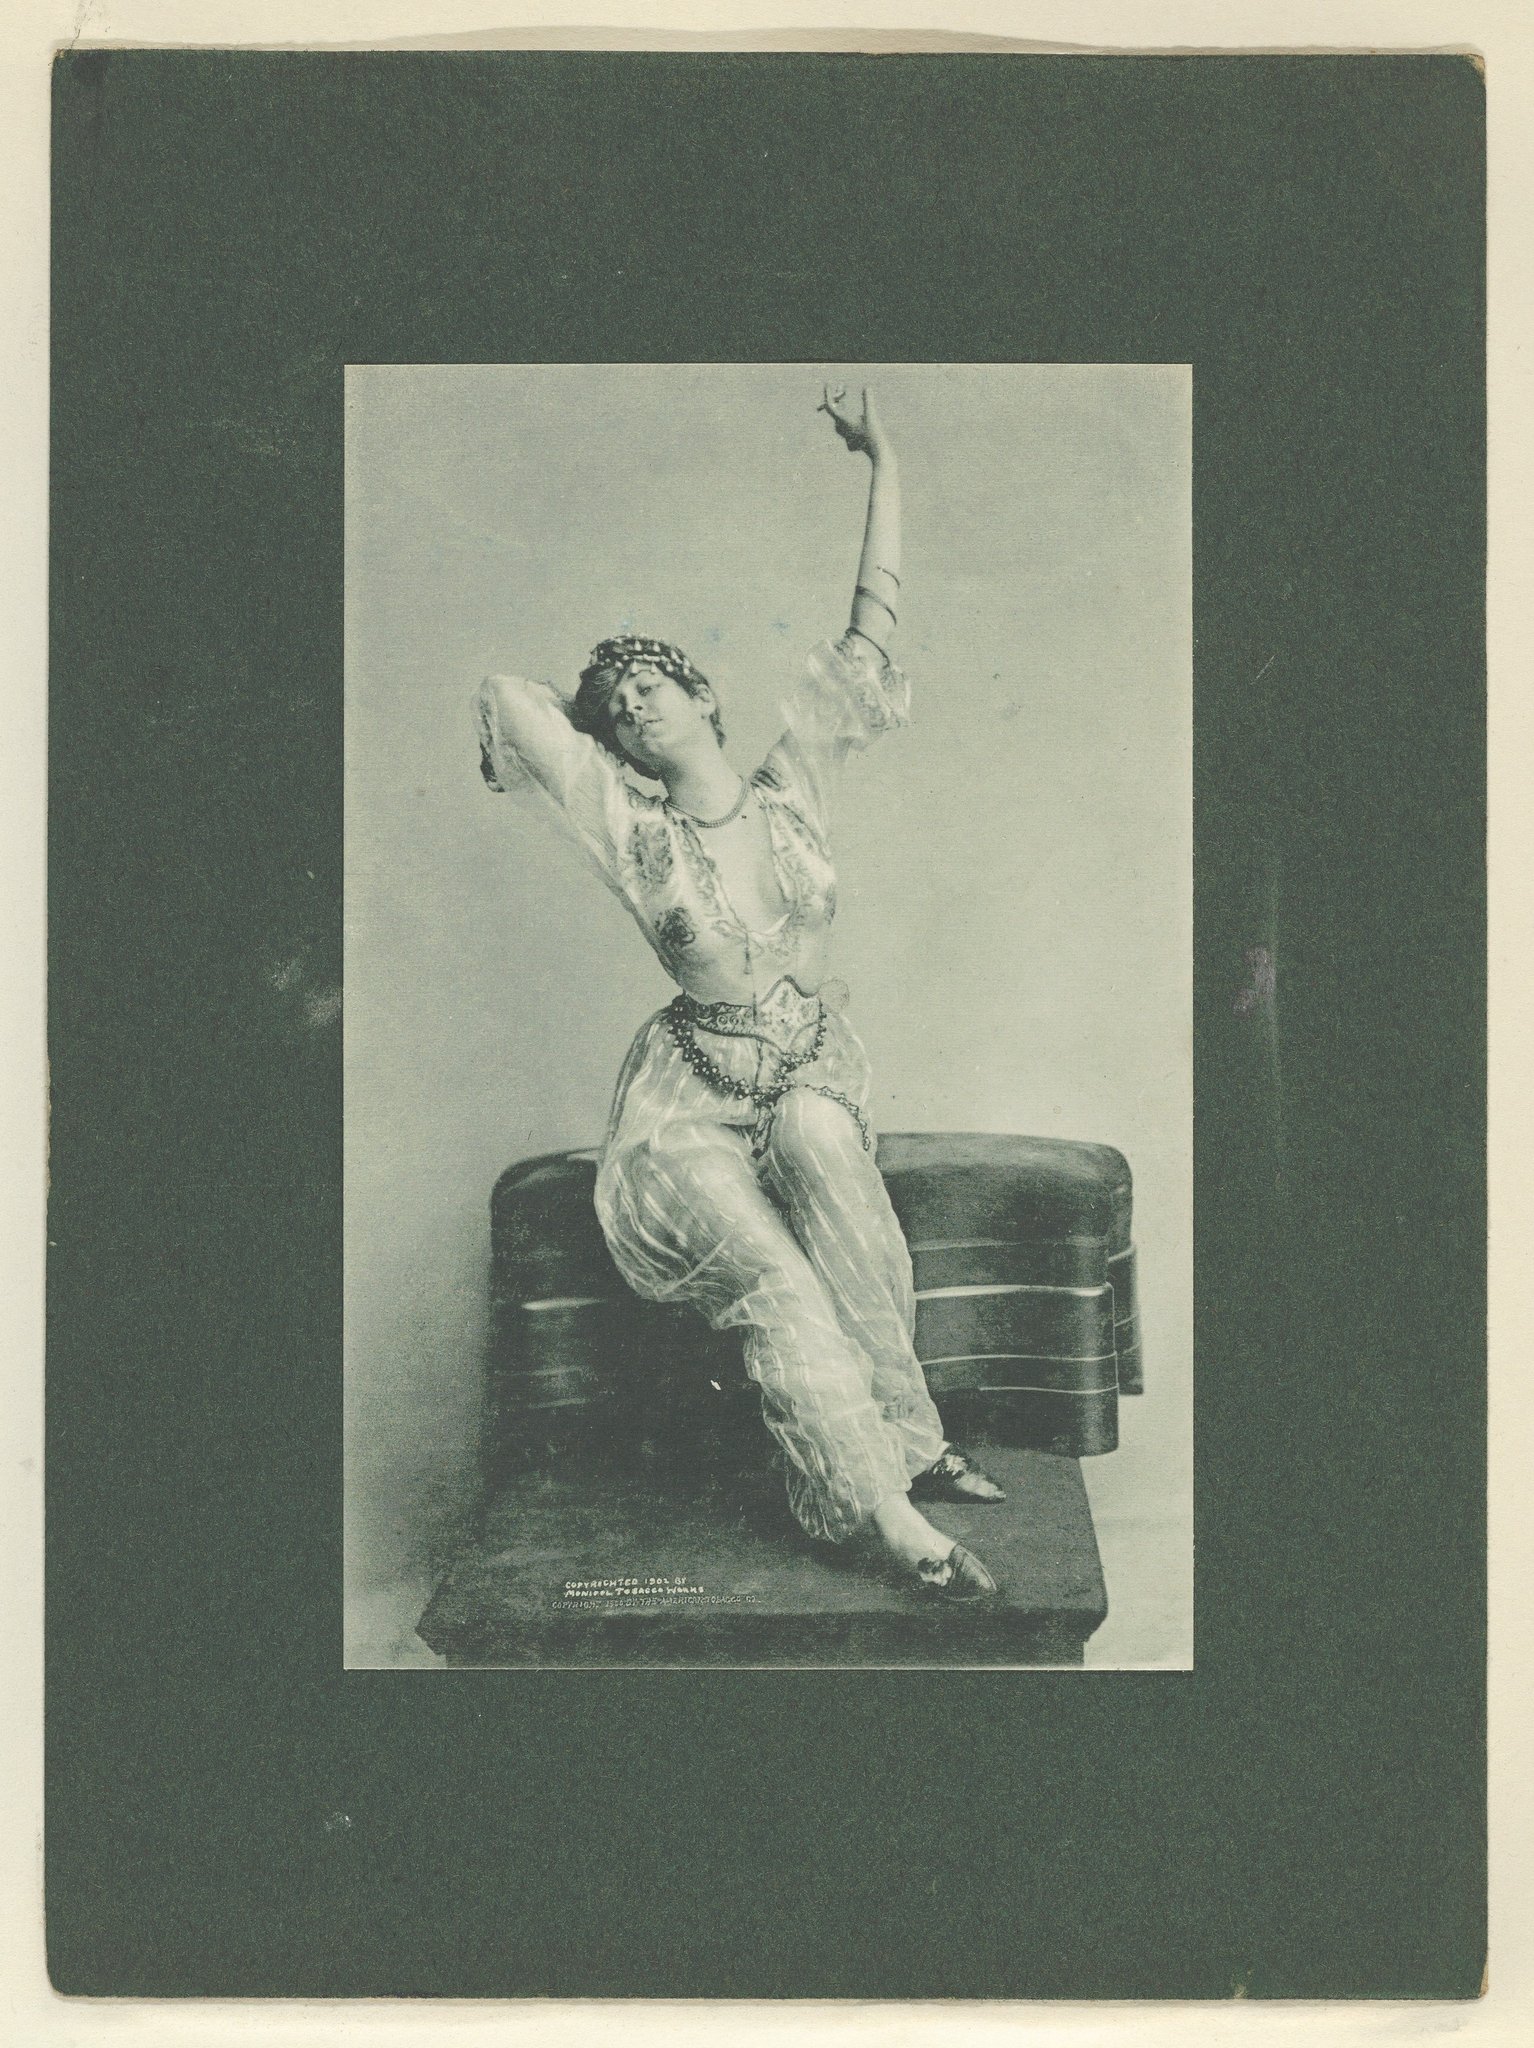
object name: print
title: Plate 10, from Little Egypt Actresses series (T2), issued by Monopole Tobacco Works to promote Khedive Egyptian Cigarettes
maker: monopole tobacco works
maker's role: publisher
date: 1902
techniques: photolithograph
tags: portraits,women,actresses